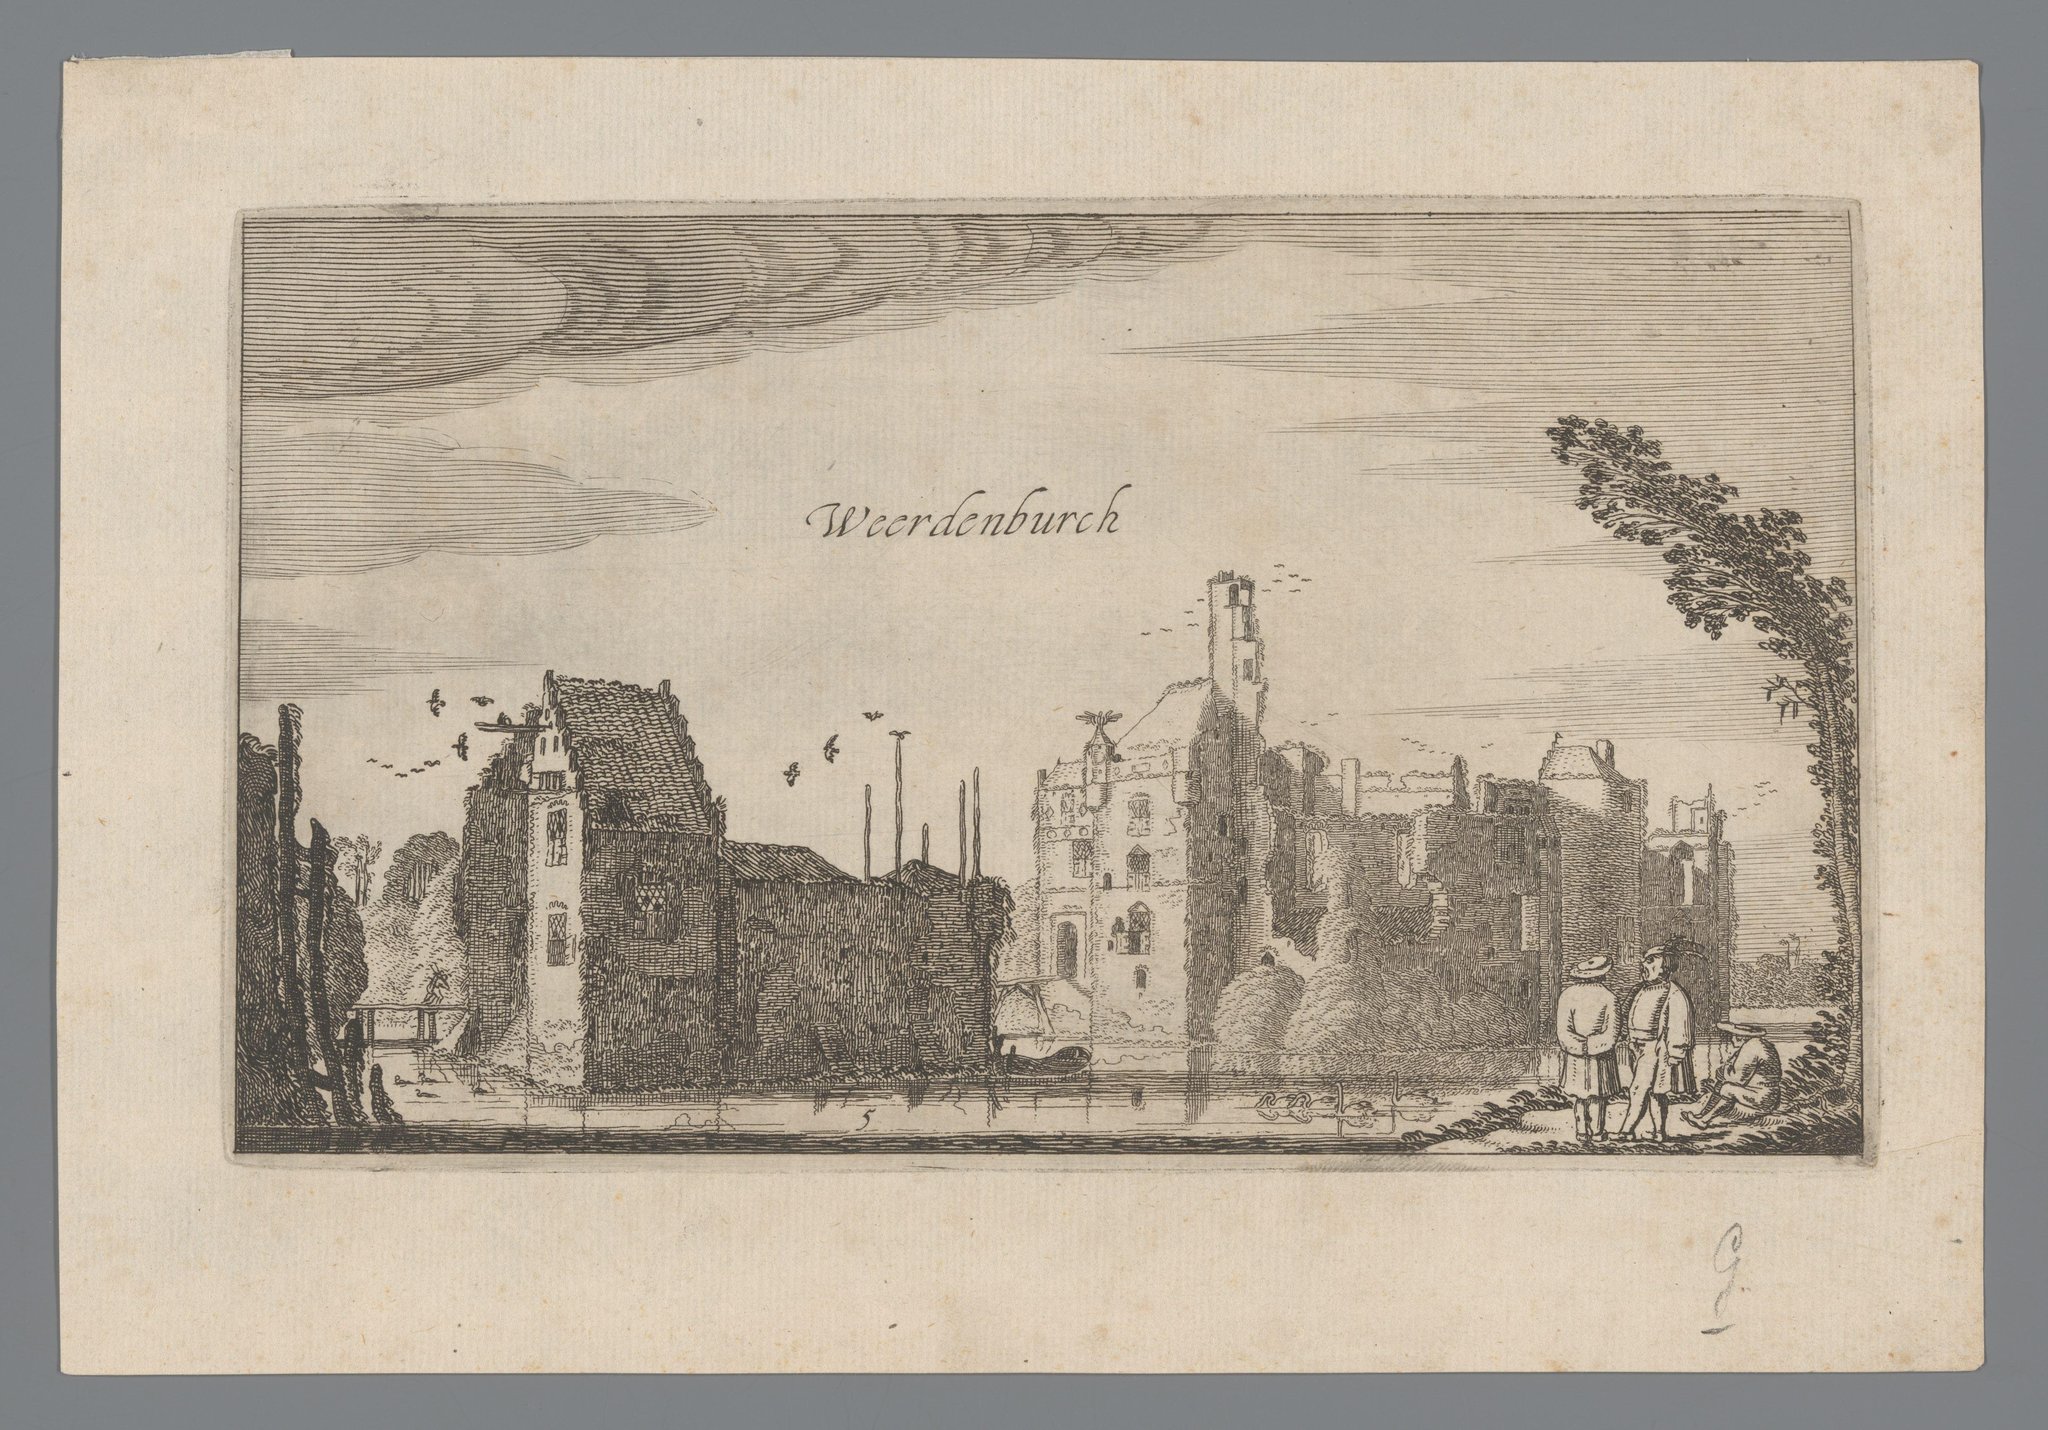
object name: print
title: Weerdenburch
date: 1616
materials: paper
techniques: etching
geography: northern netherlands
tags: landscape with ruins (+ city(-scape) with figures, staffage), ruin of a dwelling, house, castle, etc.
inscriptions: collector's mark: Lugt 2233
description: Vijfde prent uit een serie van zes prenten door Jan van de Velde II, uitgegeven bij Robert de Baudous in Amsterdam.